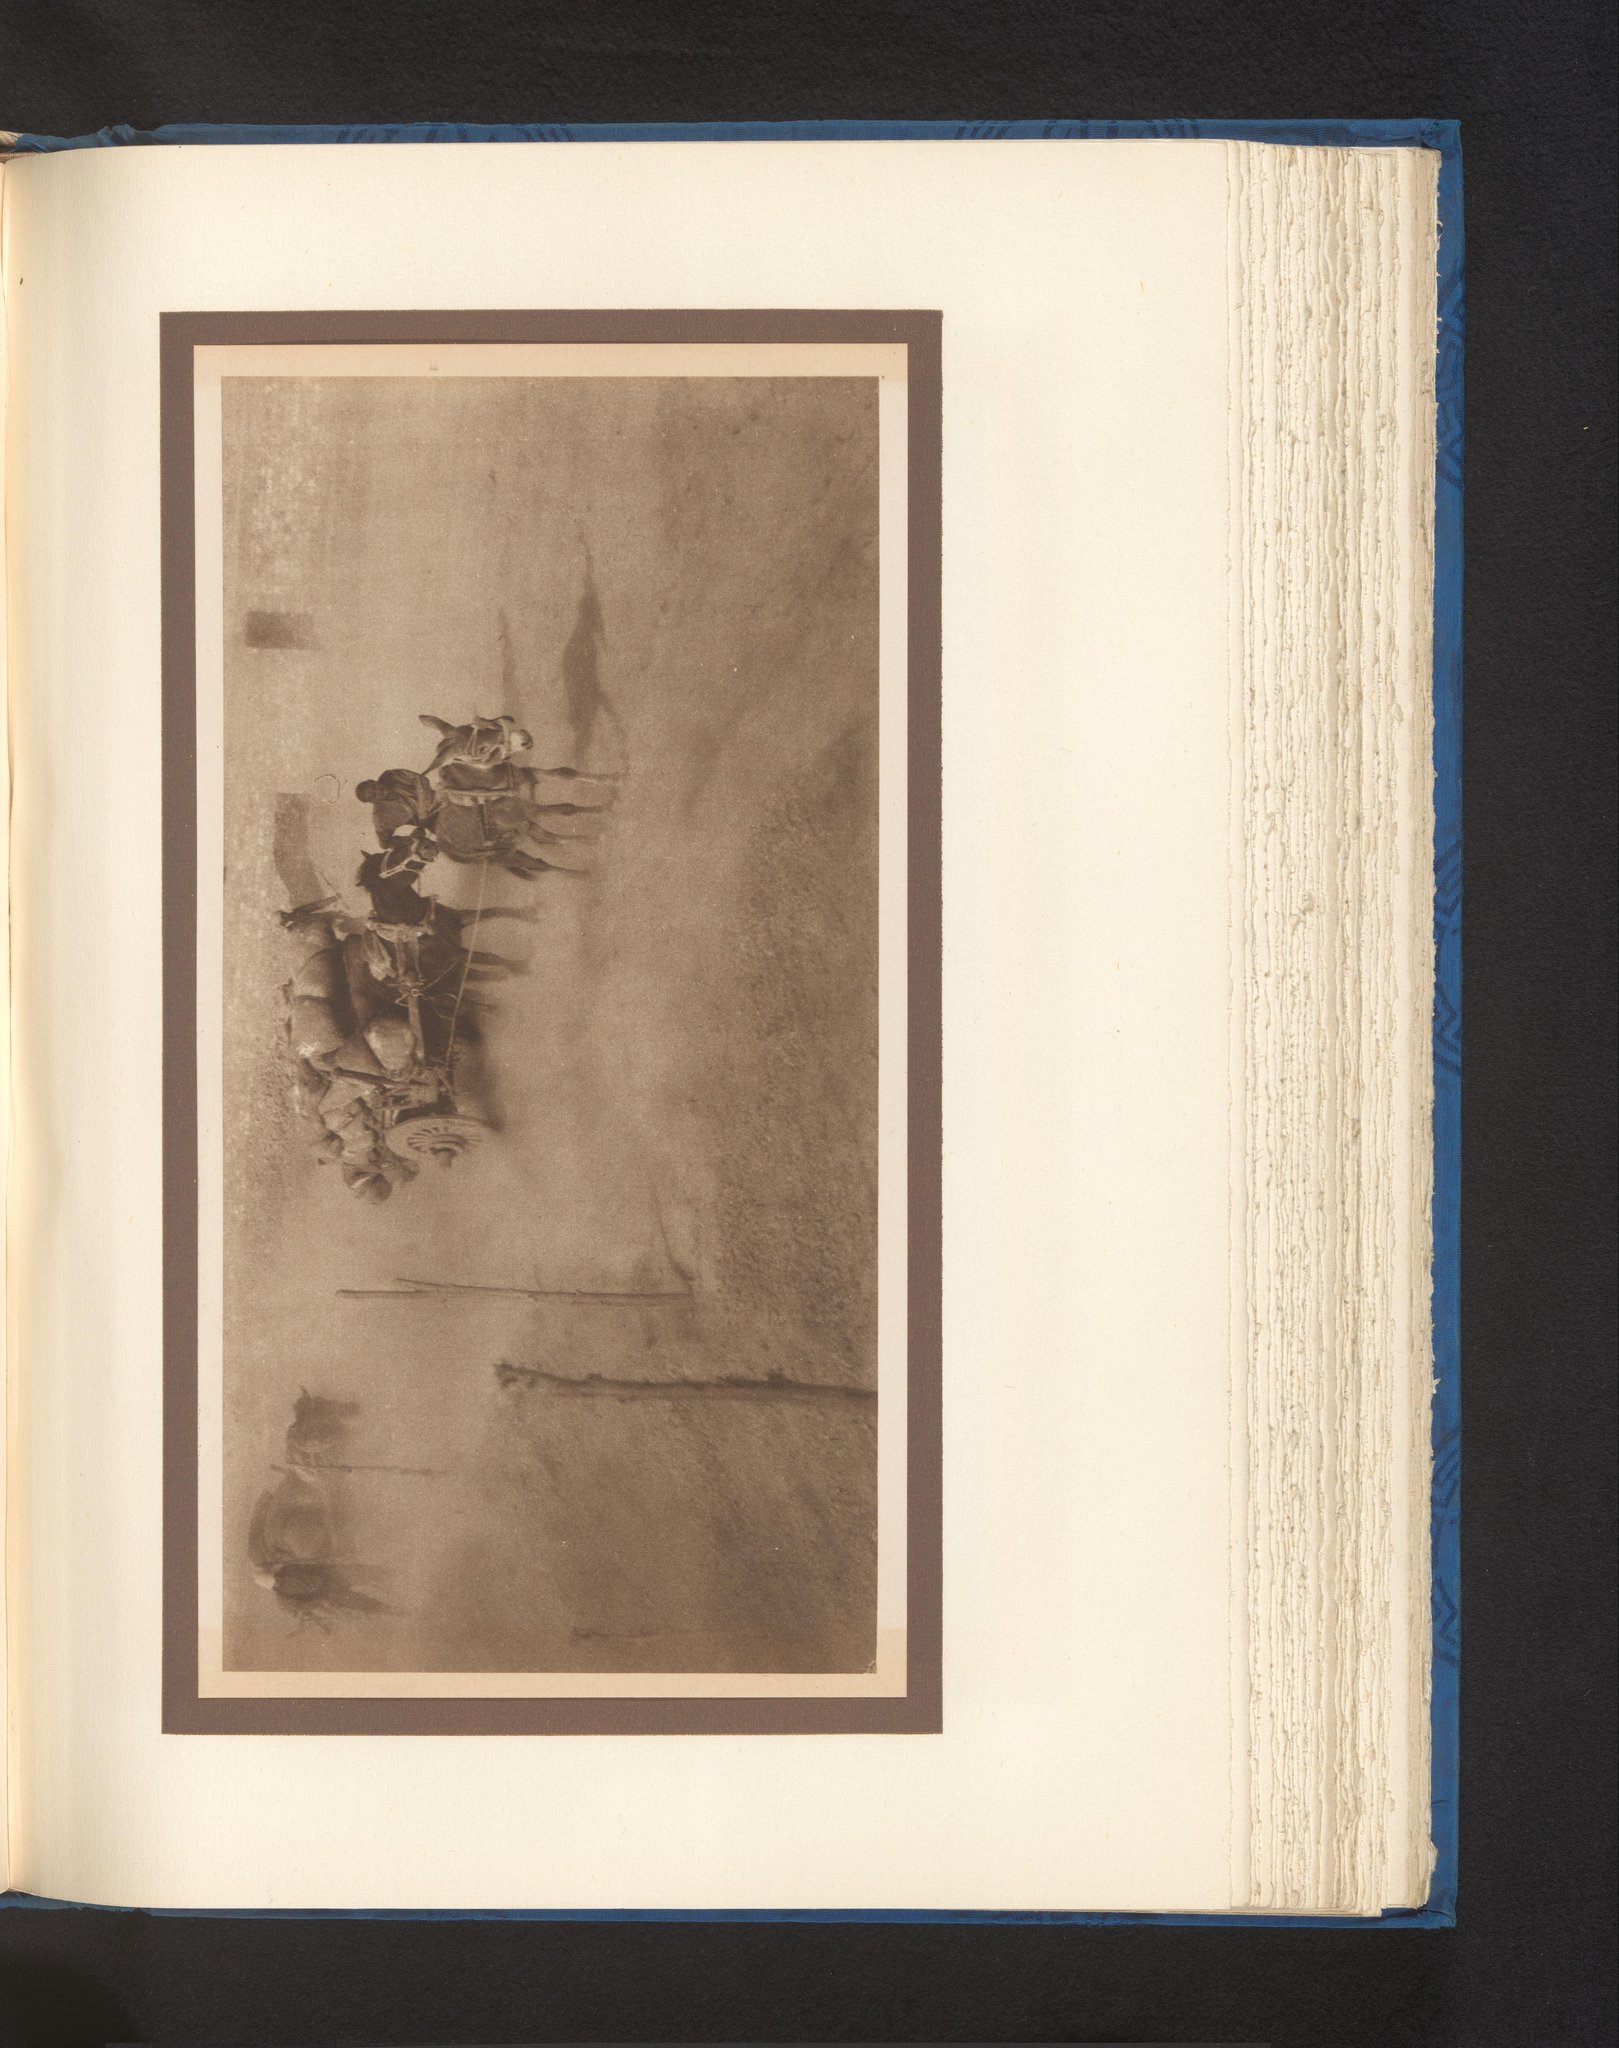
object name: page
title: Pad met door ezels getrokken kar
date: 1915-1920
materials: paper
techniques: rotogravure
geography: beijing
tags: animal traction, animal-drawn vehicle (carriage etc.), road, path, china